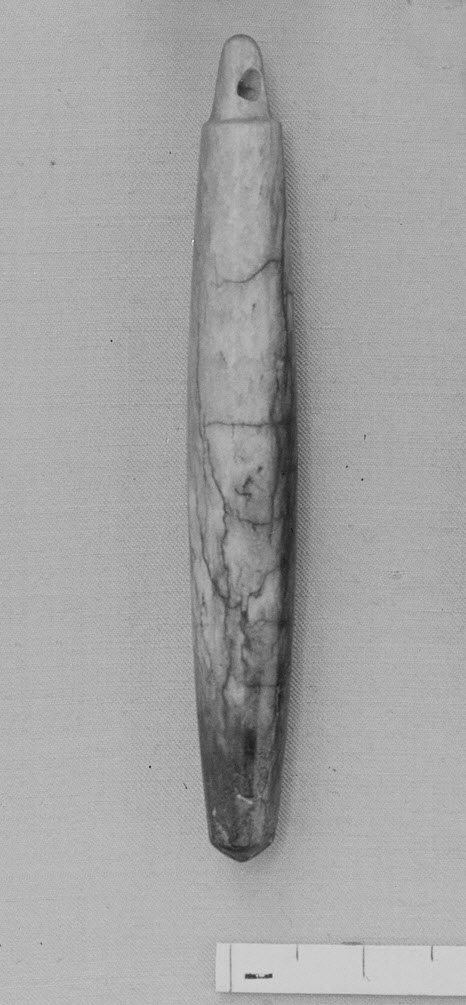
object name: pendant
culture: chinese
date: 3200-2000 BCE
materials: jade